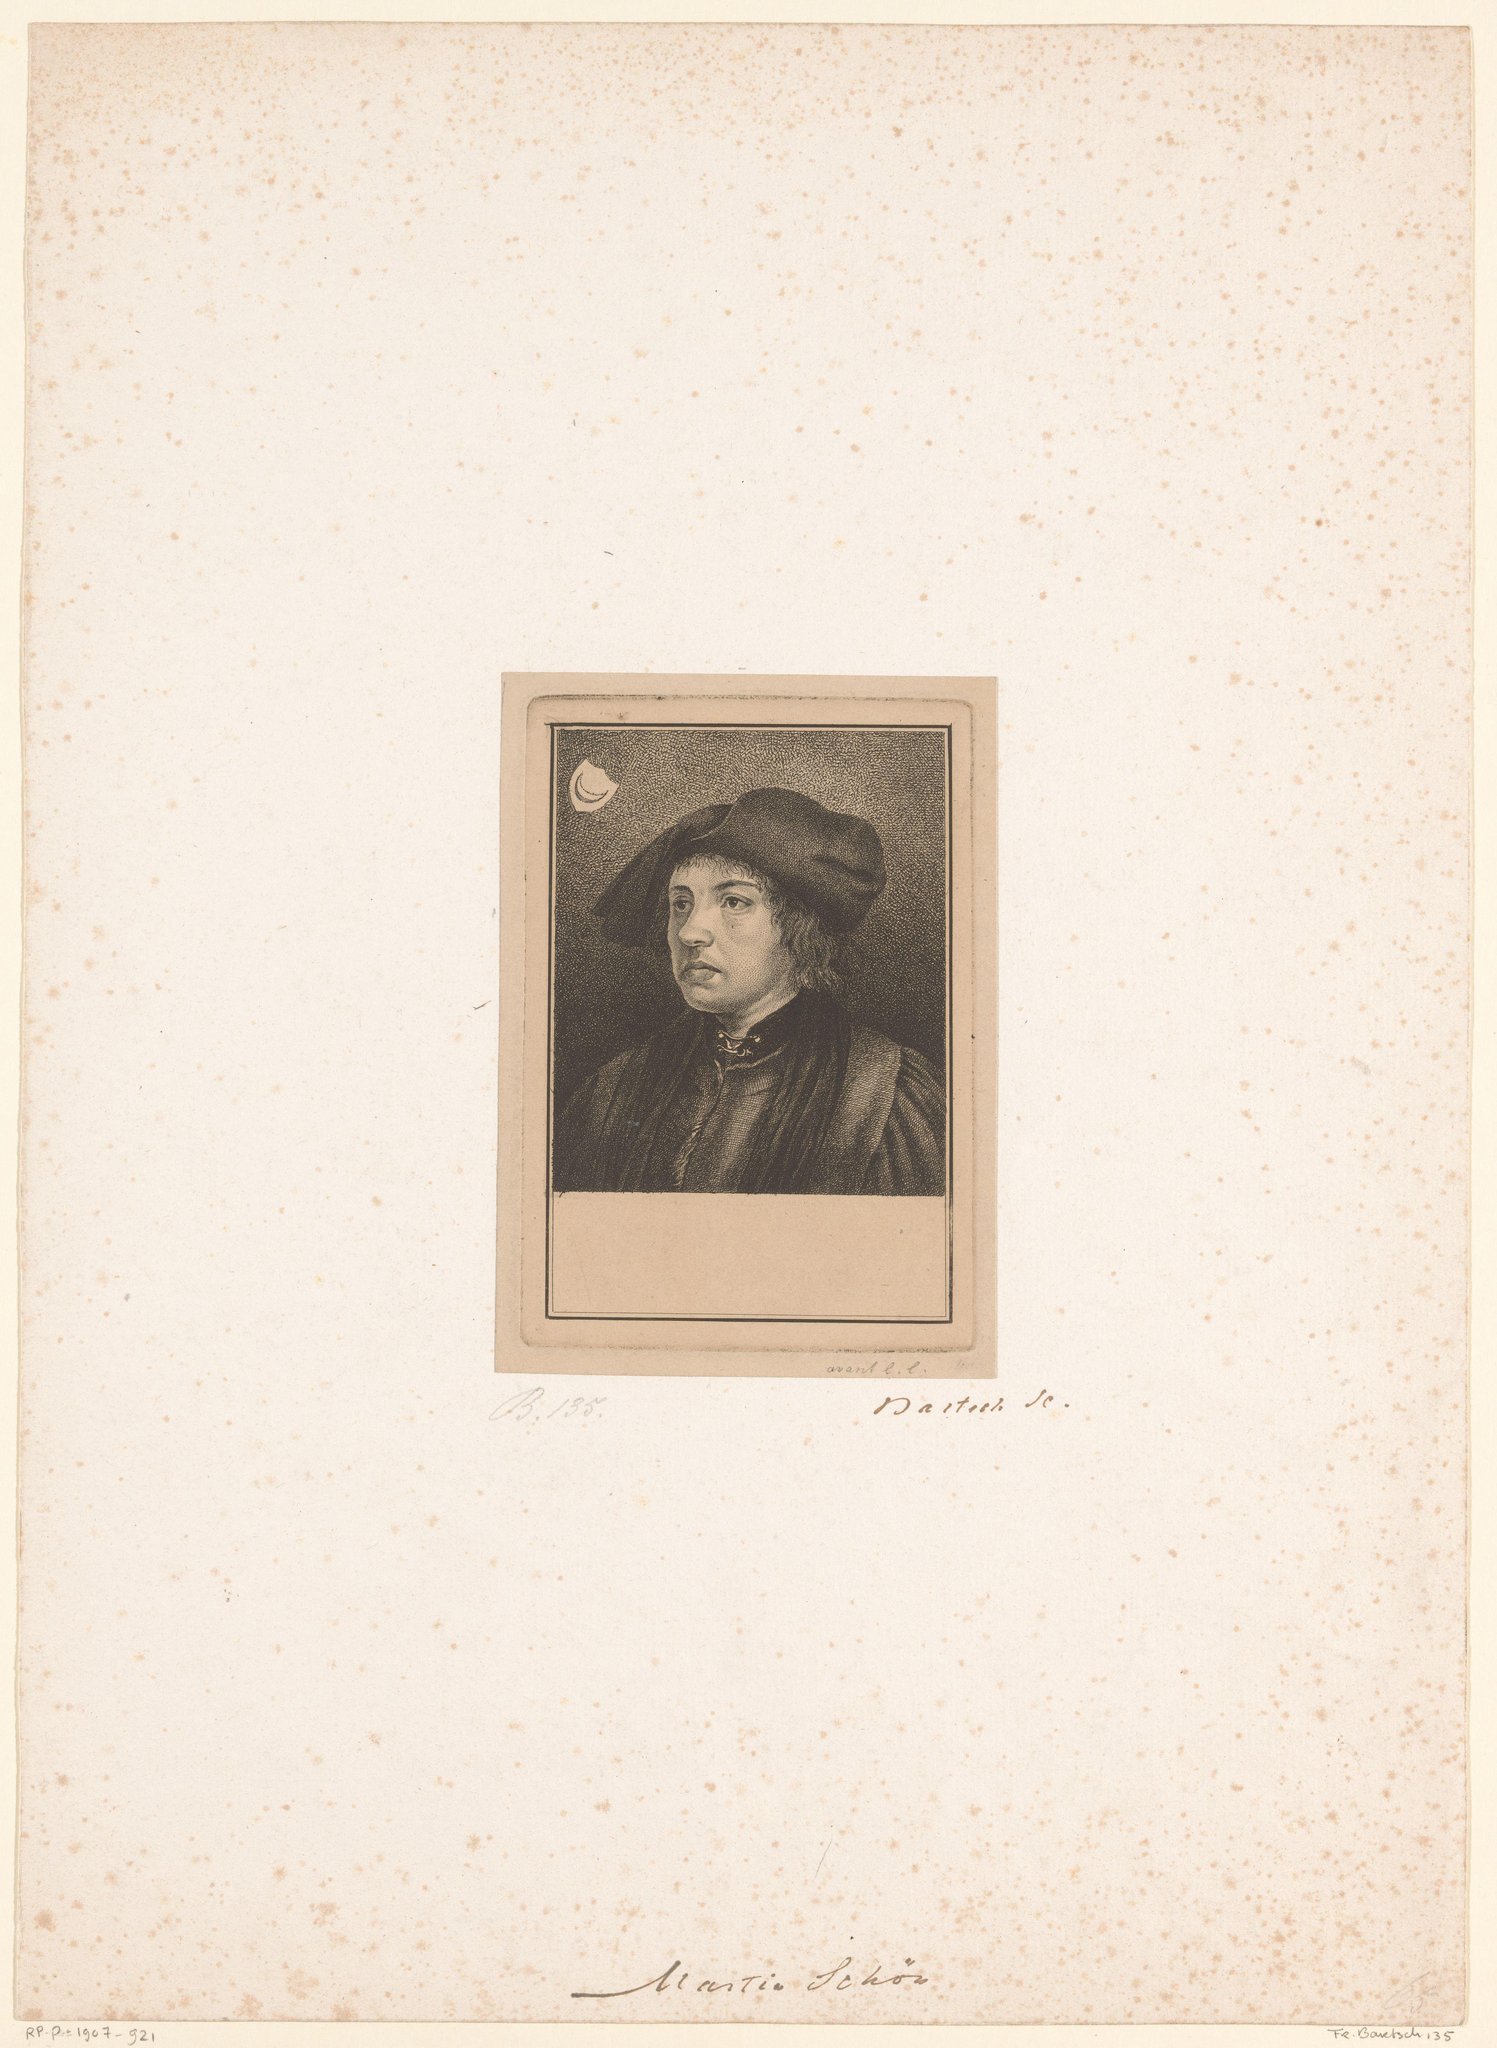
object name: print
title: Portret van Martin Schongauer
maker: adam von bartsch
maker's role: print maker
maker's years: 1757-1821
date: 1808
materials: paper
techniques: engraving, etching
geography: augsburg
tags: martin schongauer, portrait, self-portrait of artist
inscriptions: collector's mark: Lugt 2228